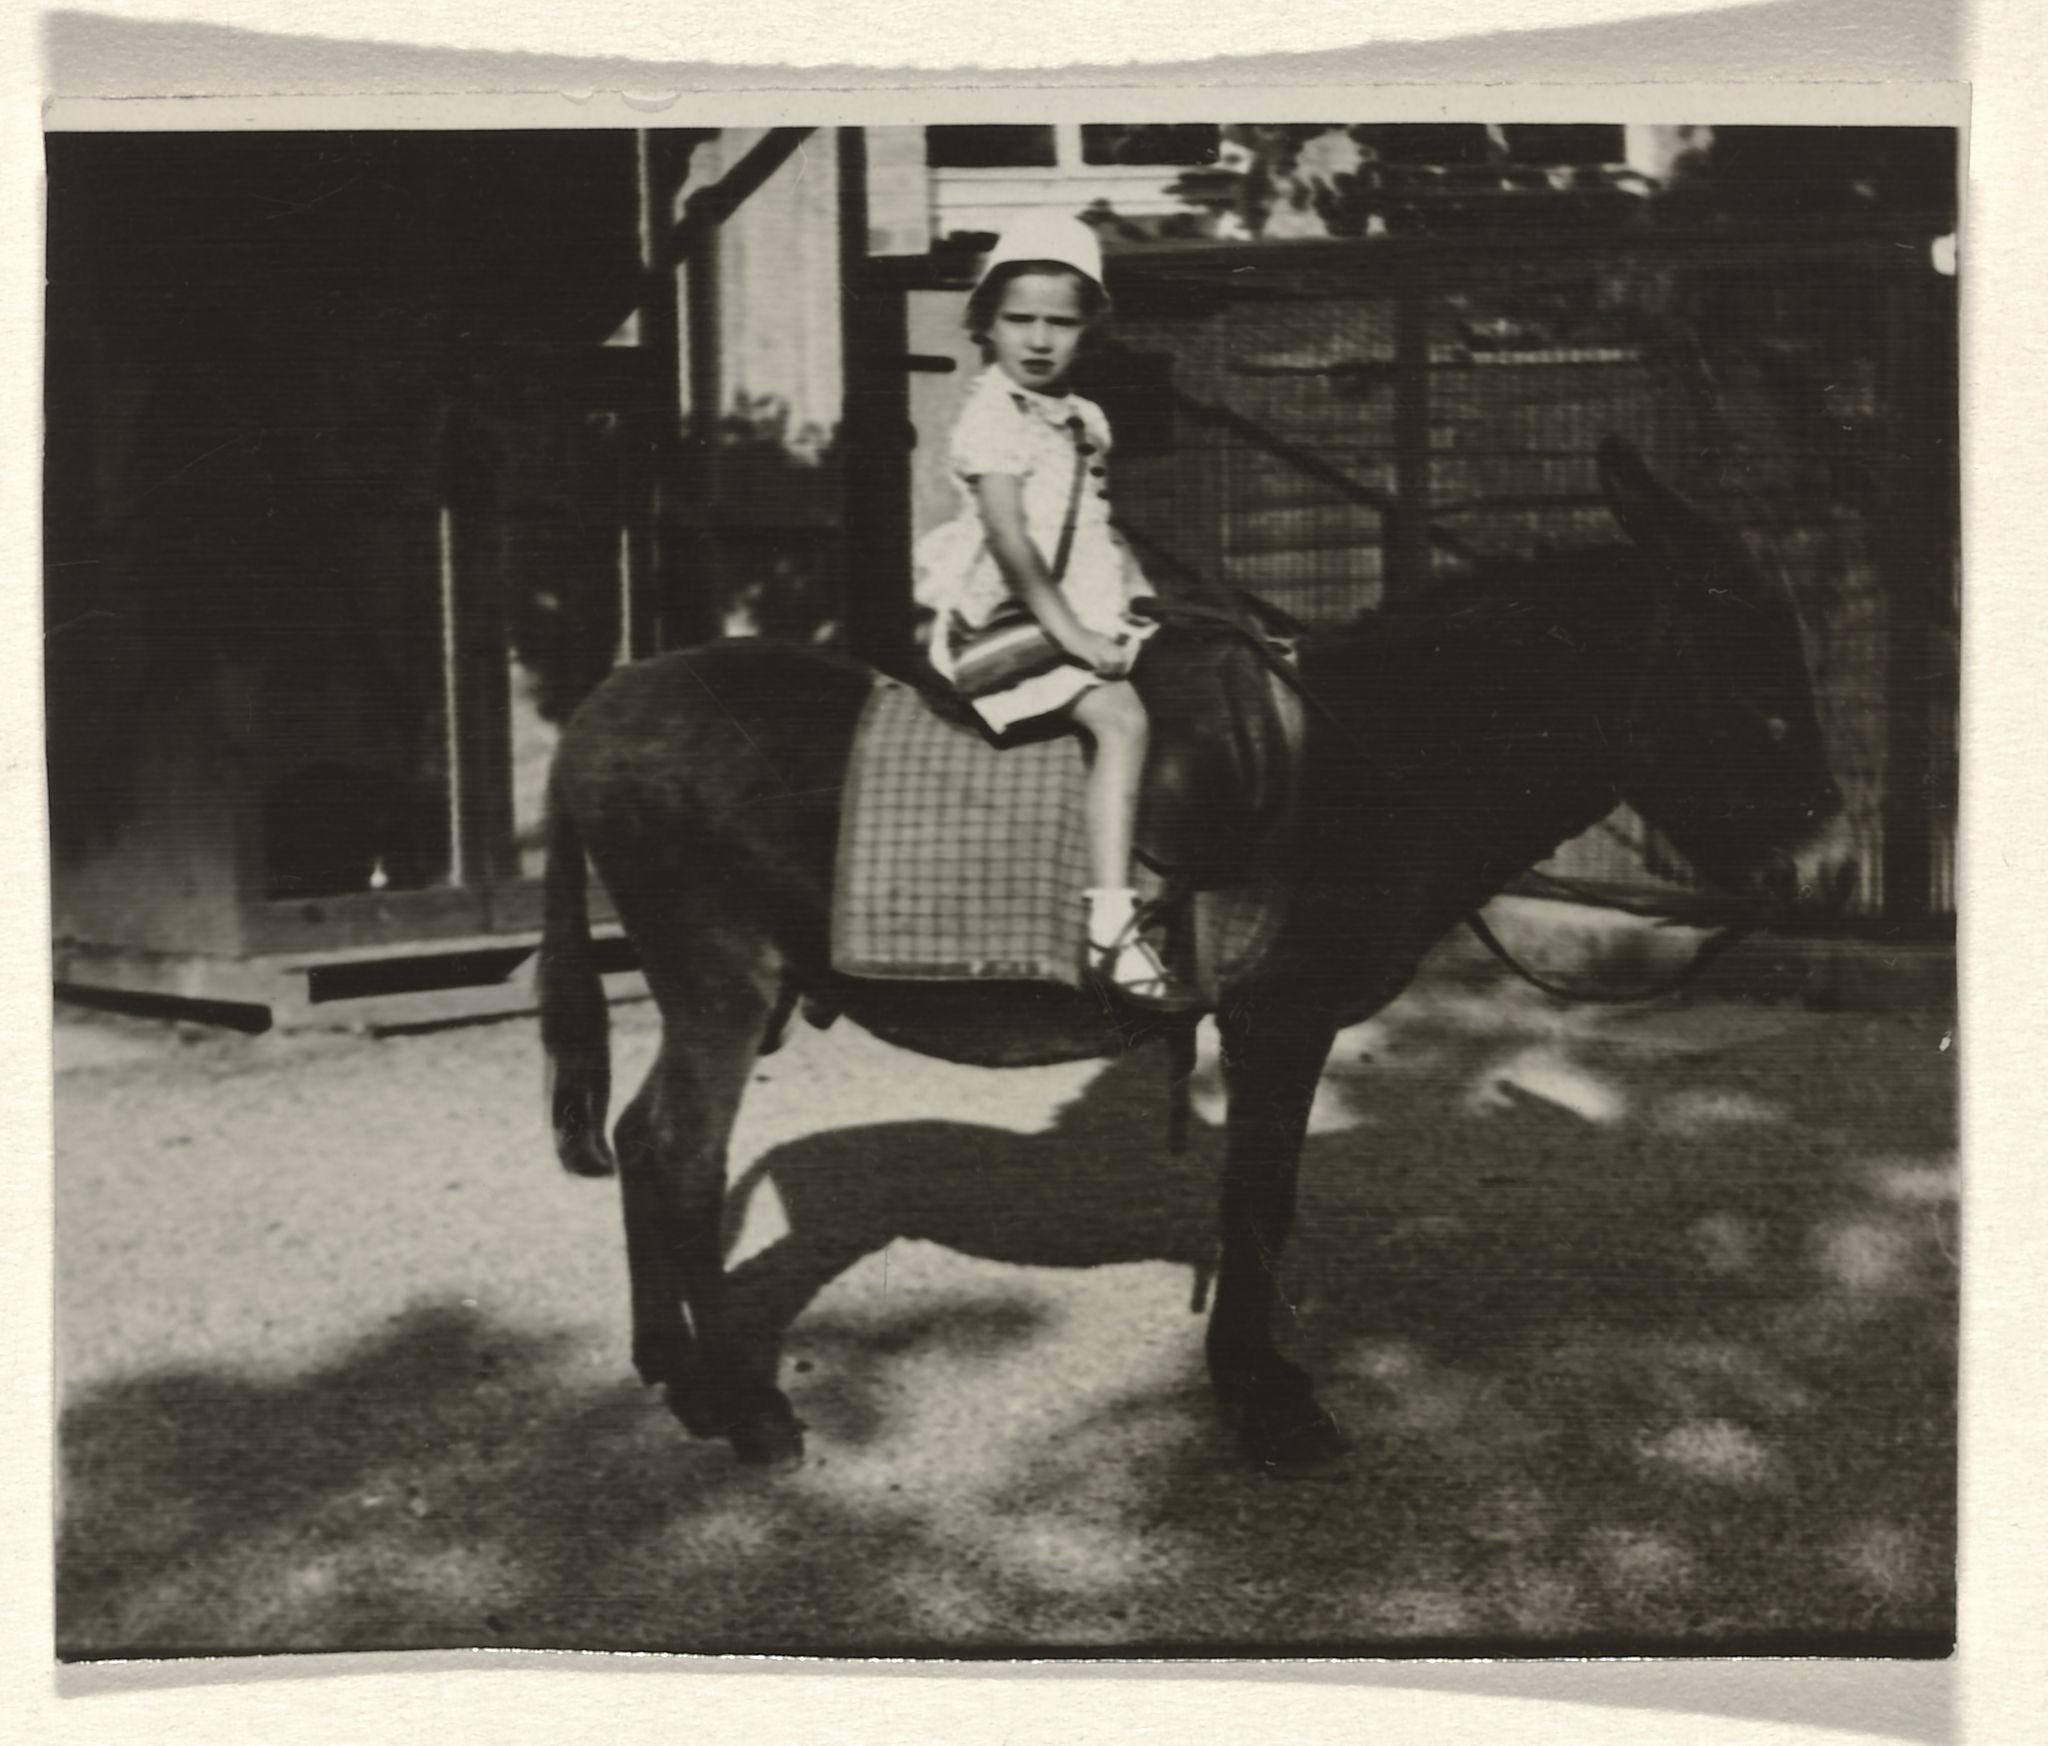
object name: photograph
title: Isabel Wachenheimer op een ezel tijdens een vakantie in de buurt van de Eibsee in augustus 1932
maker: Anonymous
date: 1908-1932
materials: photographic support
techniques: gelatin silver print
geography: bavaria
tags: leiden, isabel wachenheimer-elon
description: Dit object is onderdeel van de nalatenschap van Isabel Elon-Wachenheimer (1928-2010). Tot haar overlijden behoorde het samen met de andere objecten uit de nalatenschap tot haar privédomein van Isabel Wachenheimer. In die particuliere context zijn deze objecten tezamen en individueel aandenkens - aan de jeugd, ouders en familie van Isabel Wachenheimer vóór en tijdens de Shoah en aan haar leven na de Tweede Wereldoorlog. Isabel Wachenheimer, die van juni 1943 tot mei 1945 gevangen zat in Kamp Westerbork, Theresienstadt, Auschwitz, Lenzing a/d Oberdonau (een buitenkamp van Mauthausen), overleefde de Shoah. Haar ouders – Eugène Wachenheimer en Else Wachenheimer-Moos - werden op 14 oktober 1944 in Auschwitz-Birkenau vermoord.